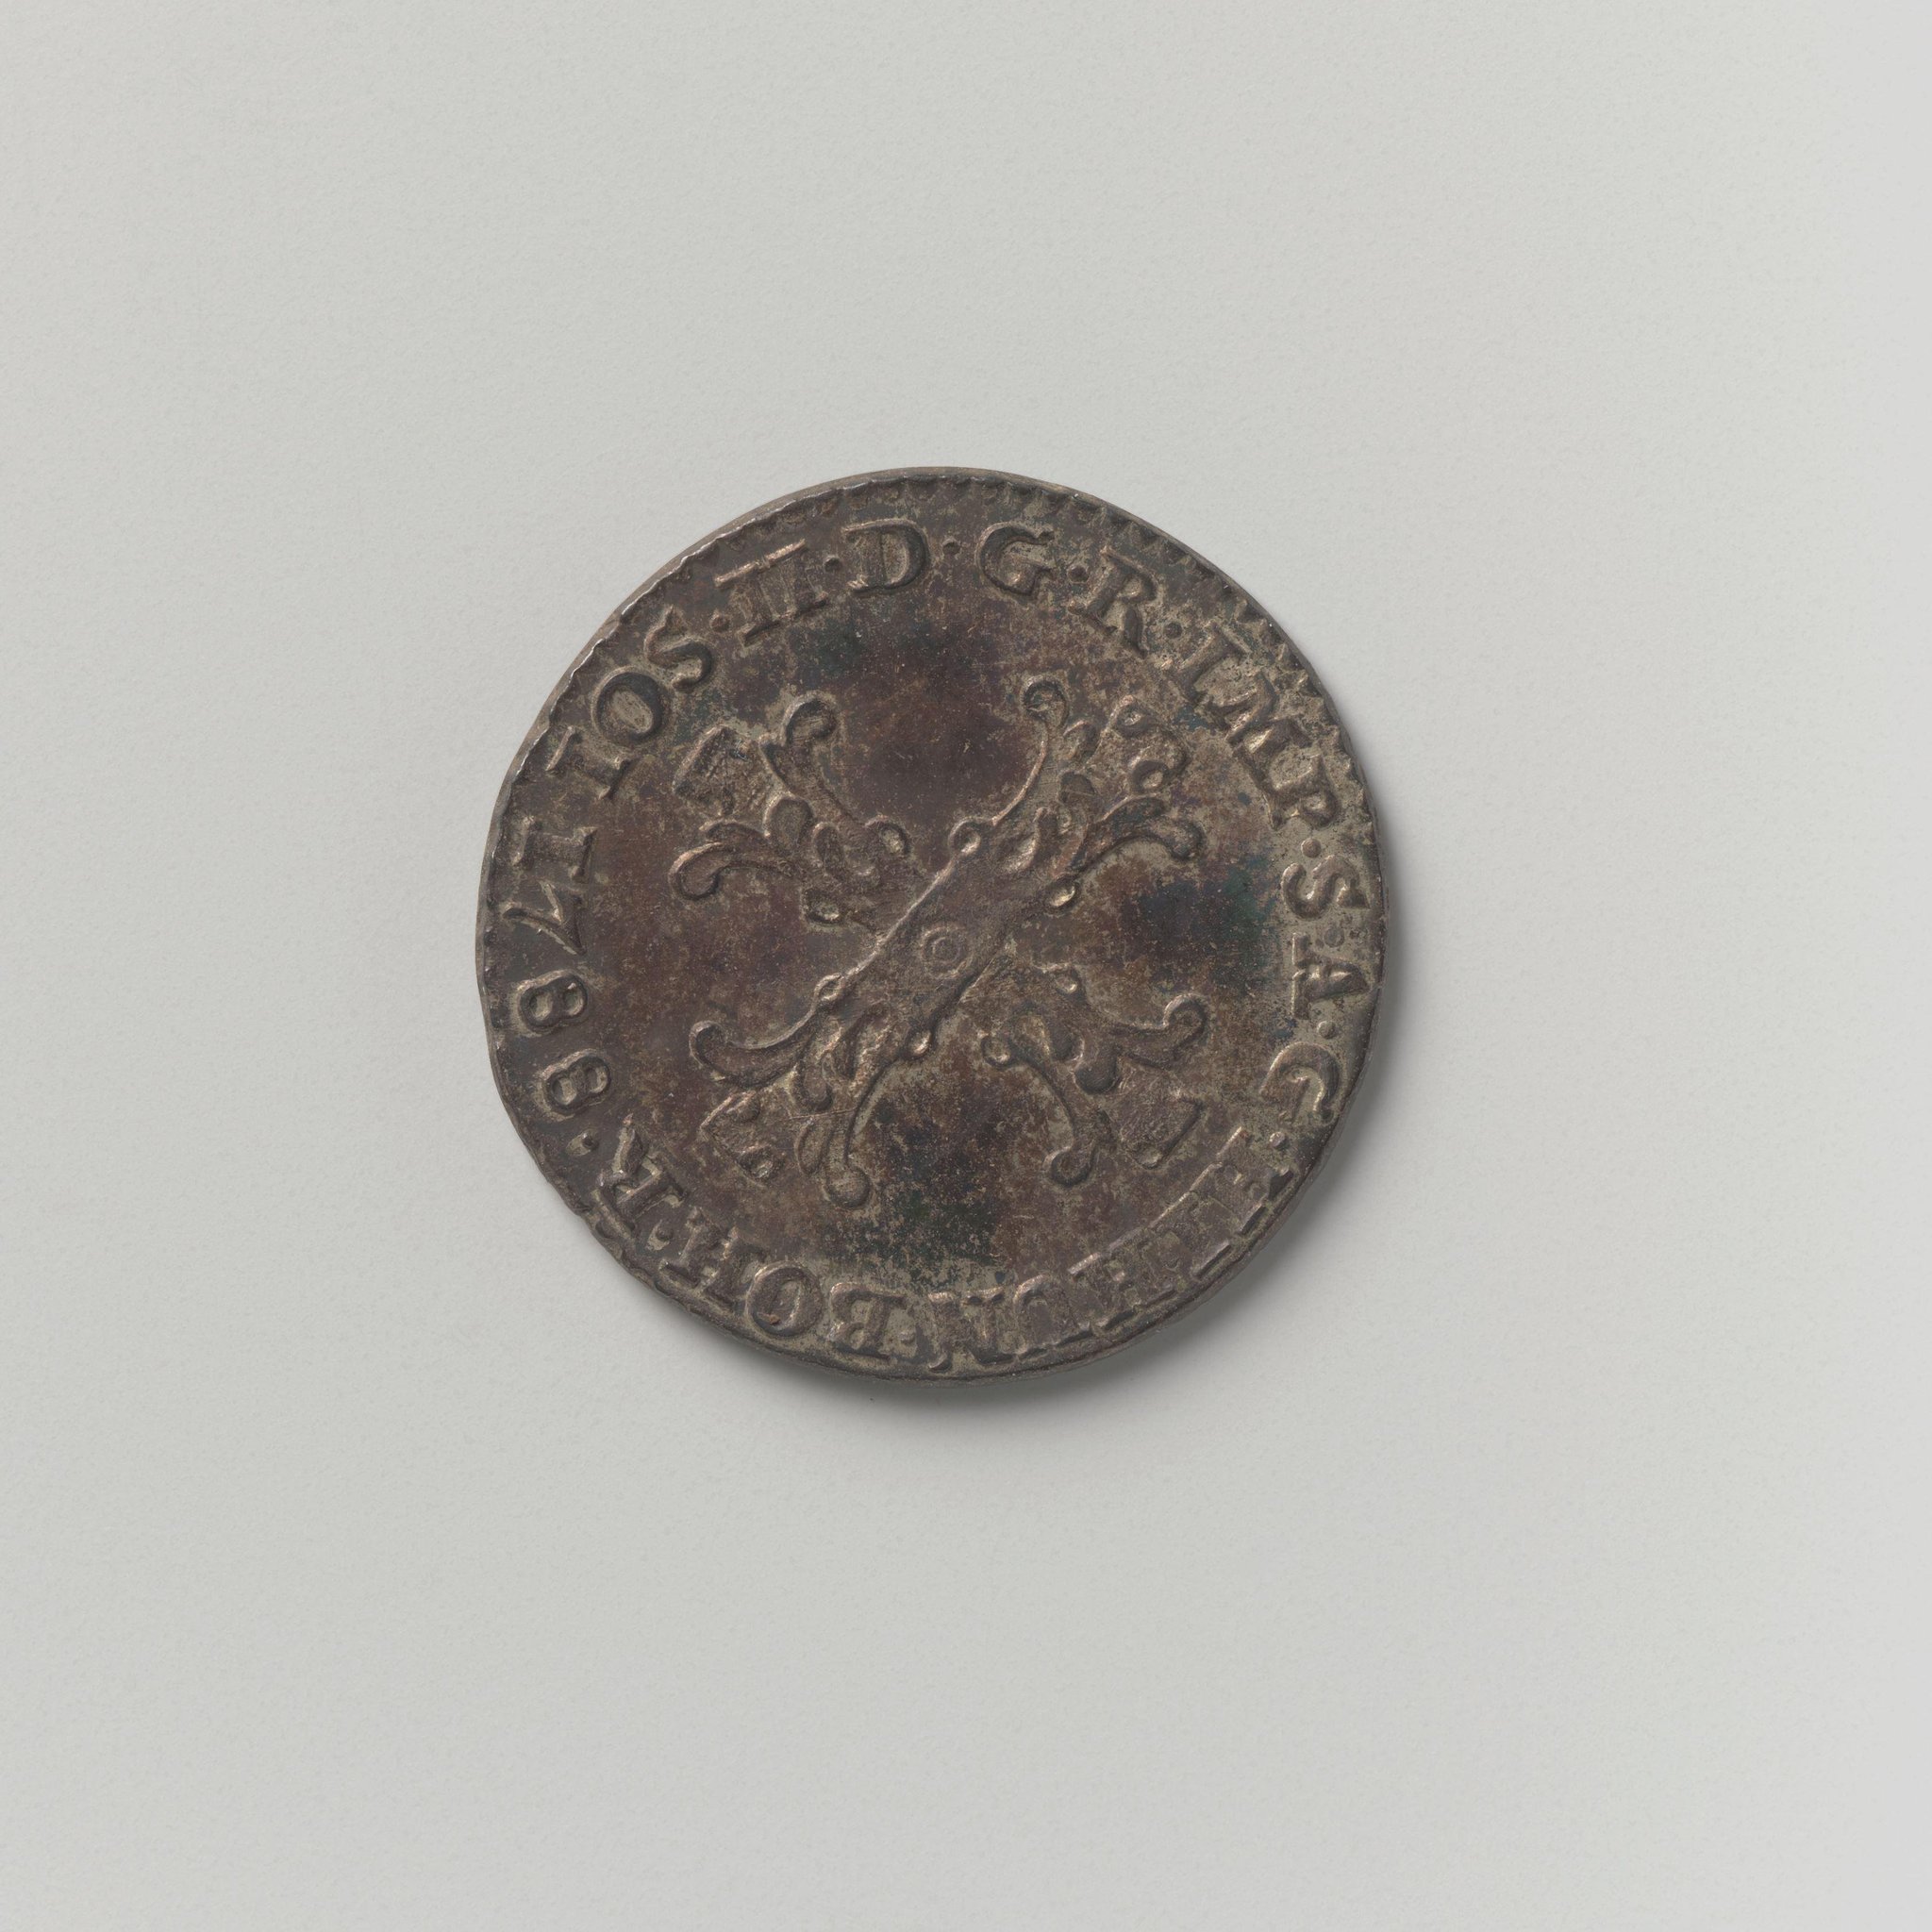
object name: coin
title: 10 oorden uit Brabant van Jozef II,1788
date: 1788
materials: silver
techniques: striking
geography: brussels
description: Zilveren munt. Voorzijde: X [=10] in de vorm van een stokkenkruis. Jaartal in omschrift onderaan. Keerzijde: met keten van het gulden vlies omhangen gekroond samengesteld wapenschild. Onder ramsvacht, in omschrift engelenkop. Kartelrand.